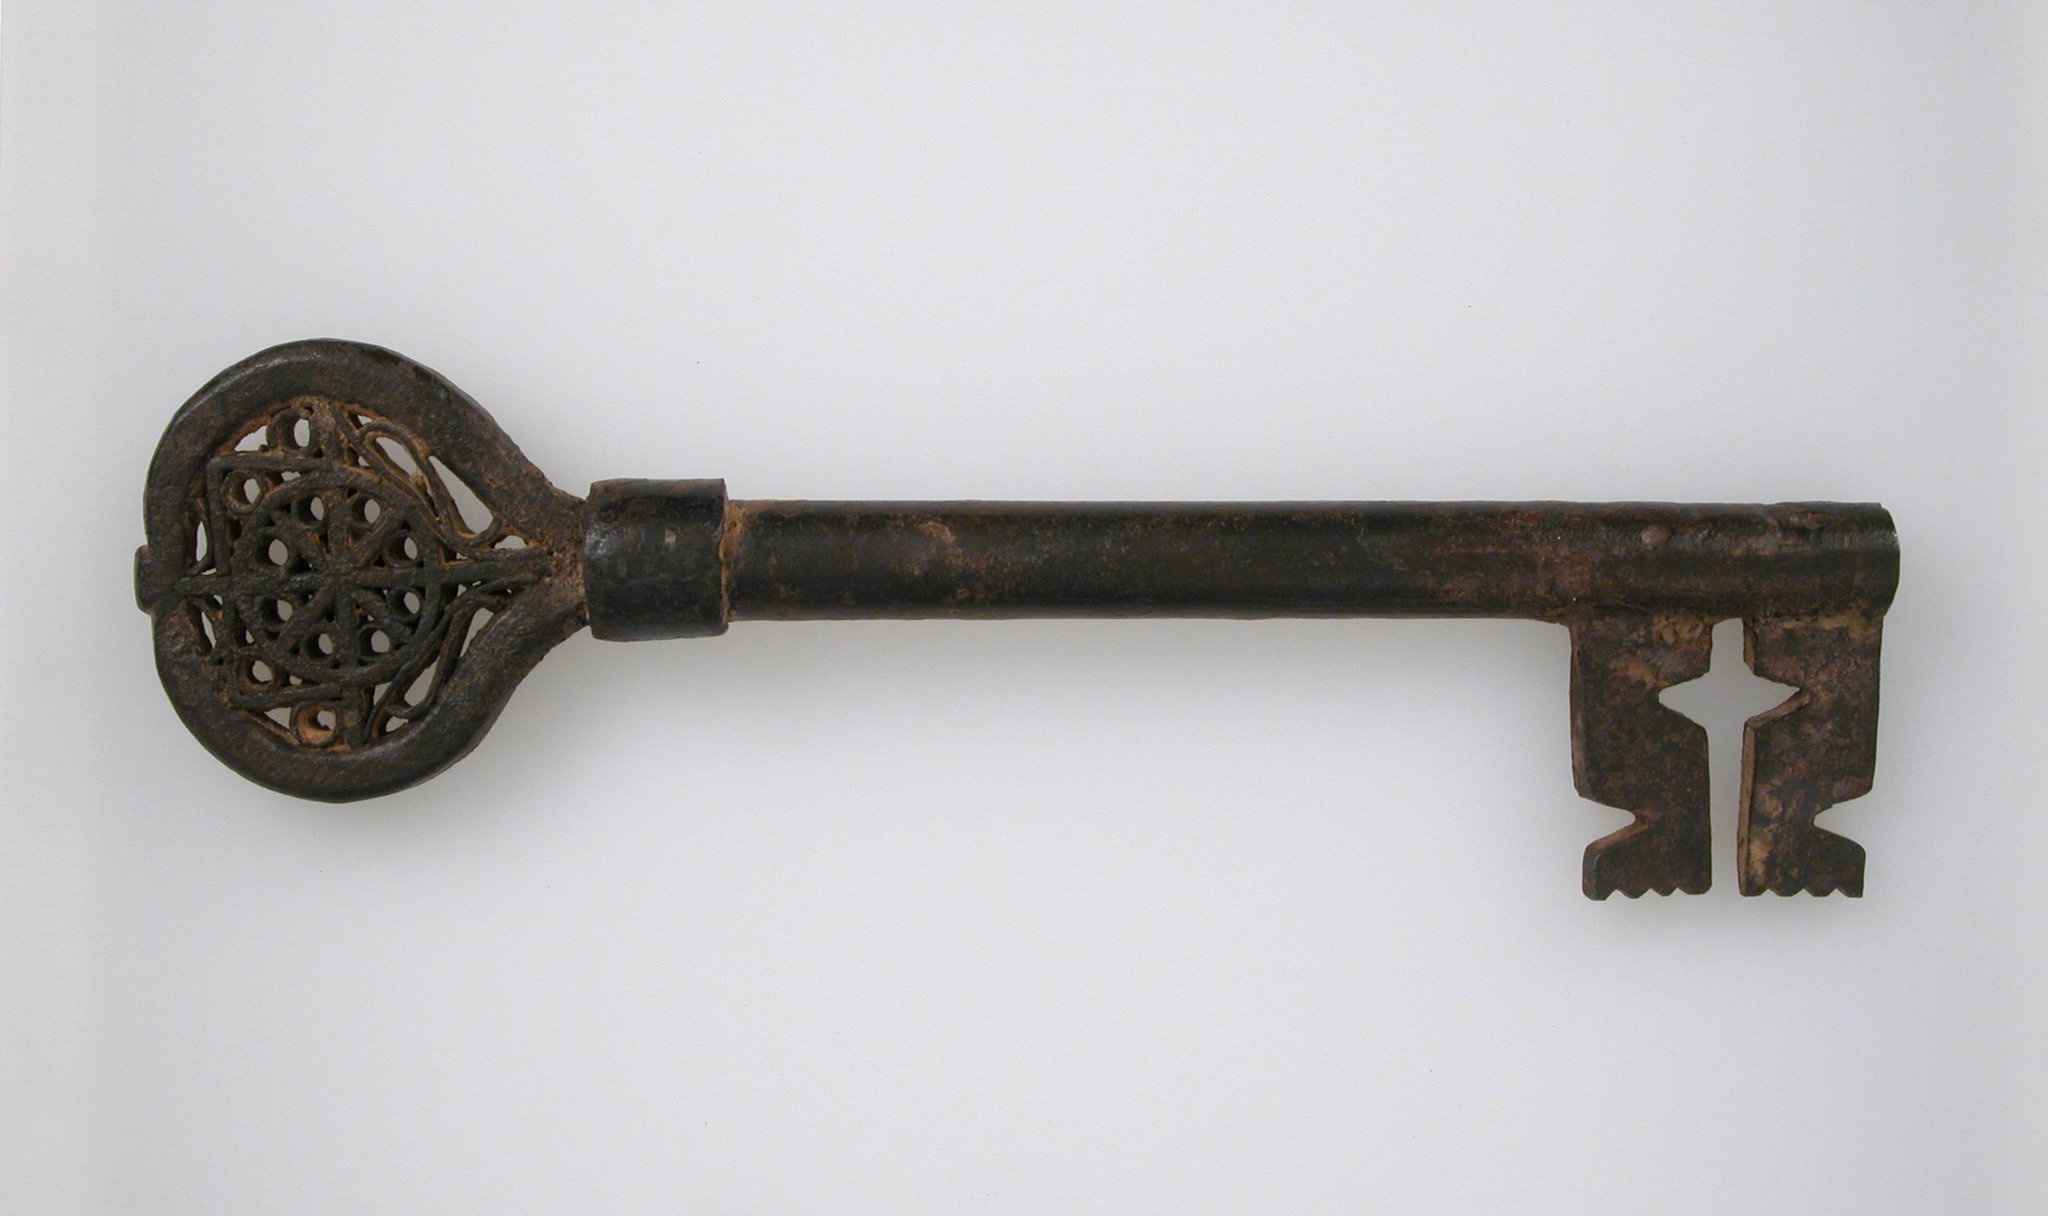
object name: key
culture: german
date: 1401-1500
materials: iron